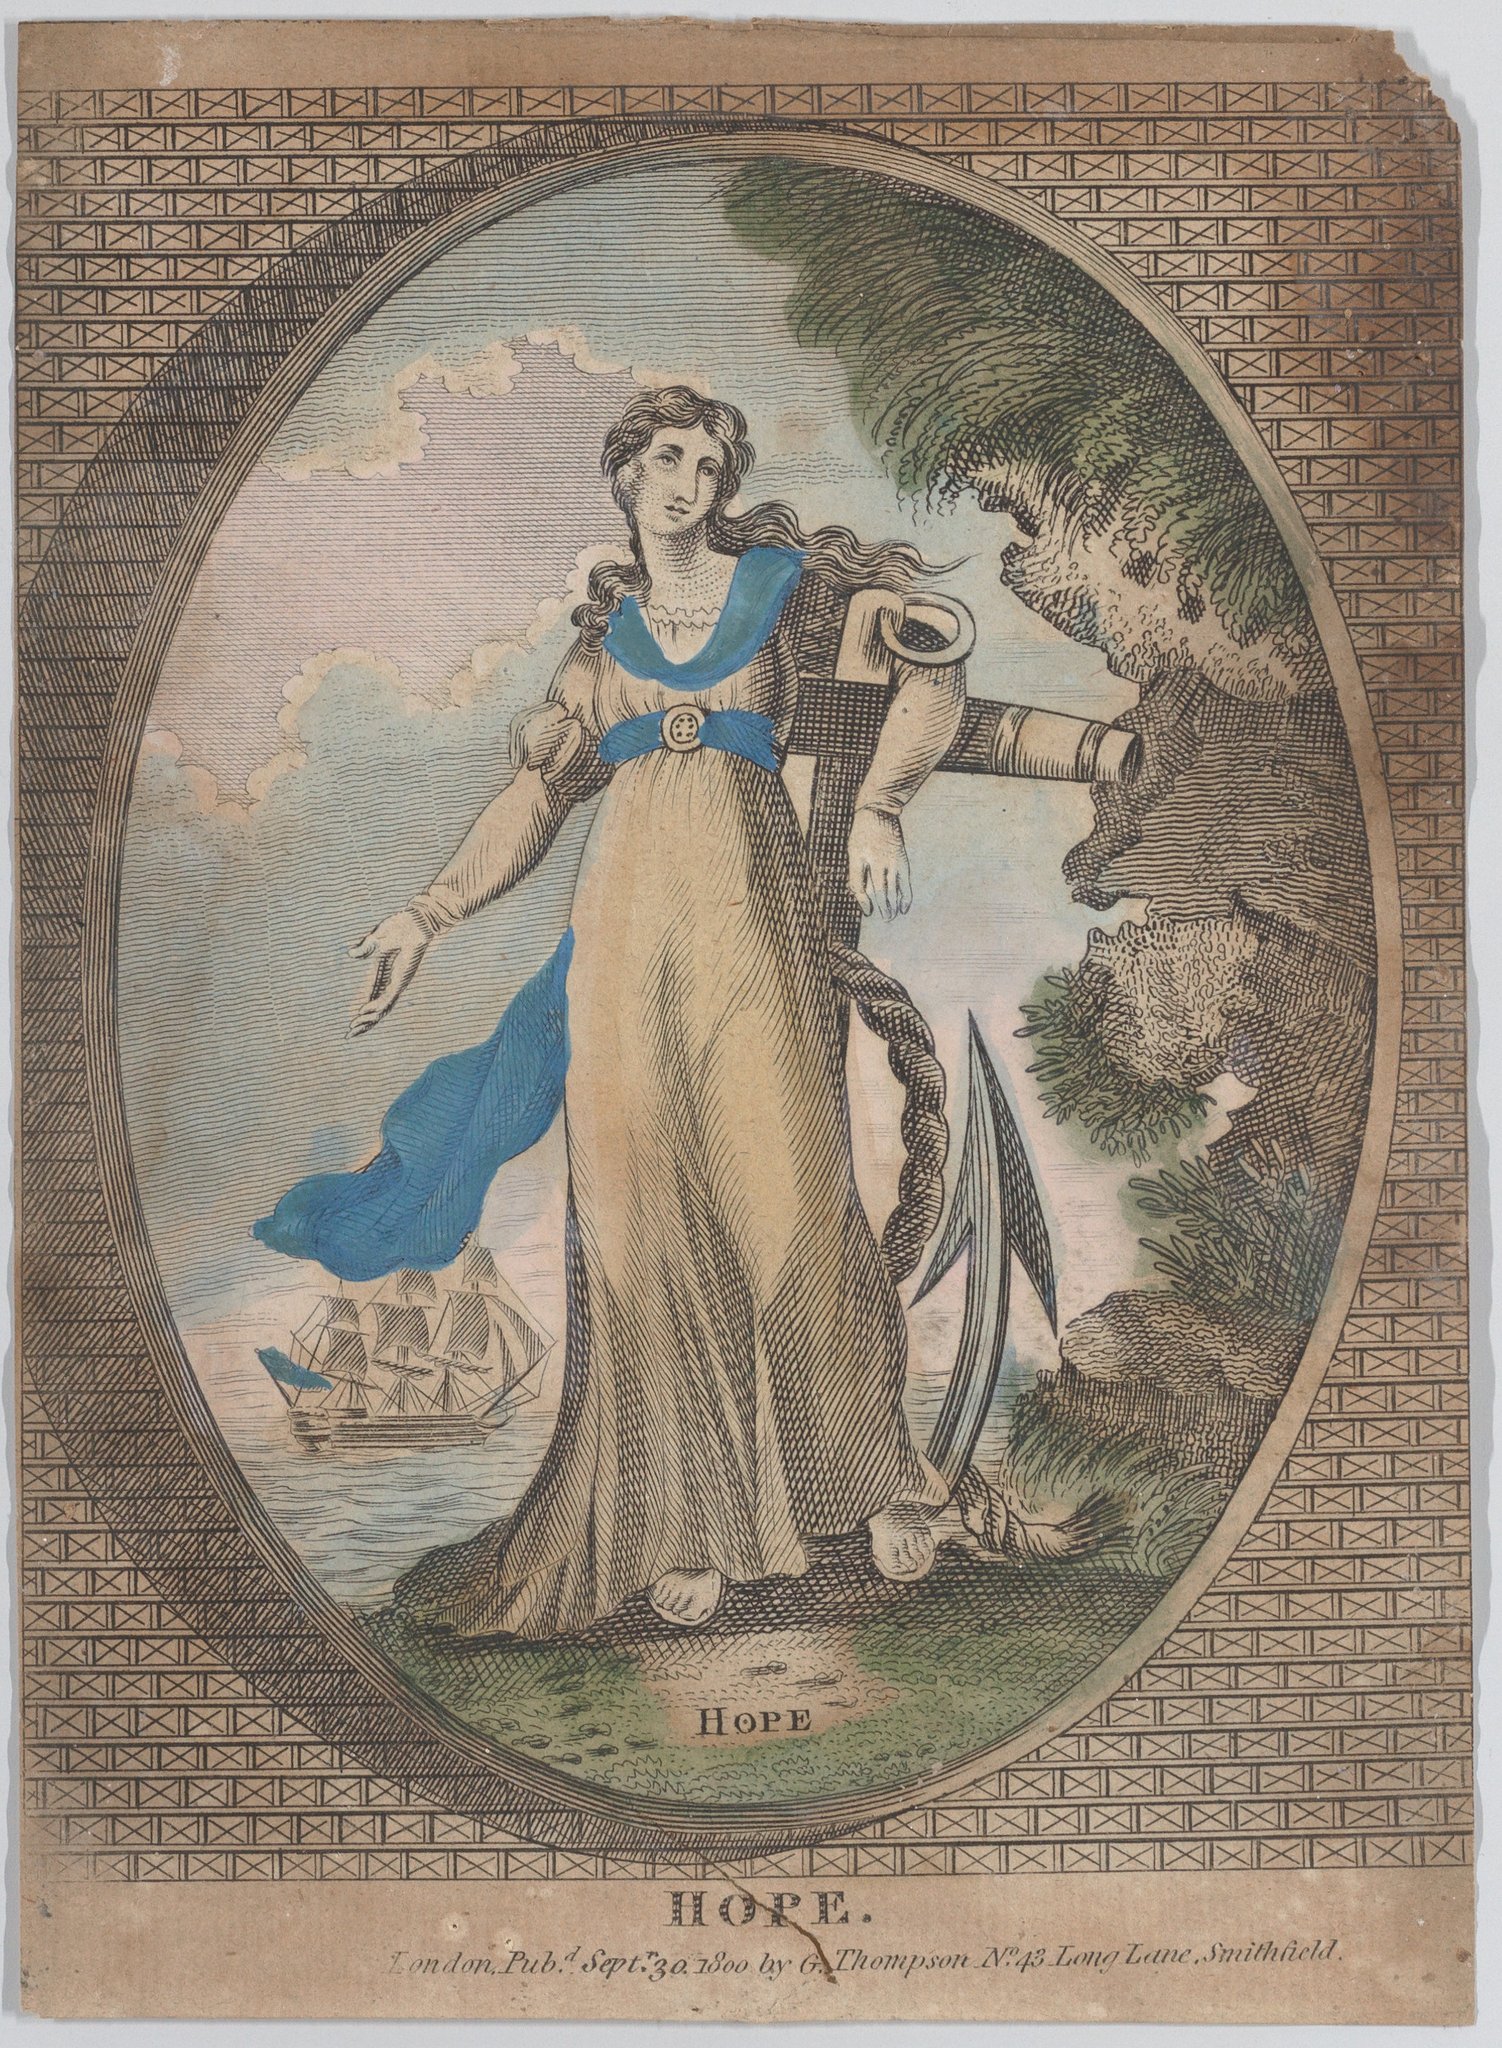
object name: print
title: Hope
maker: anonymous, british, 19th century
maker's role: artist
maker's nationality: british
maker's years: 1800-1900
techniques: etching, hand coloring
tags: women,ships